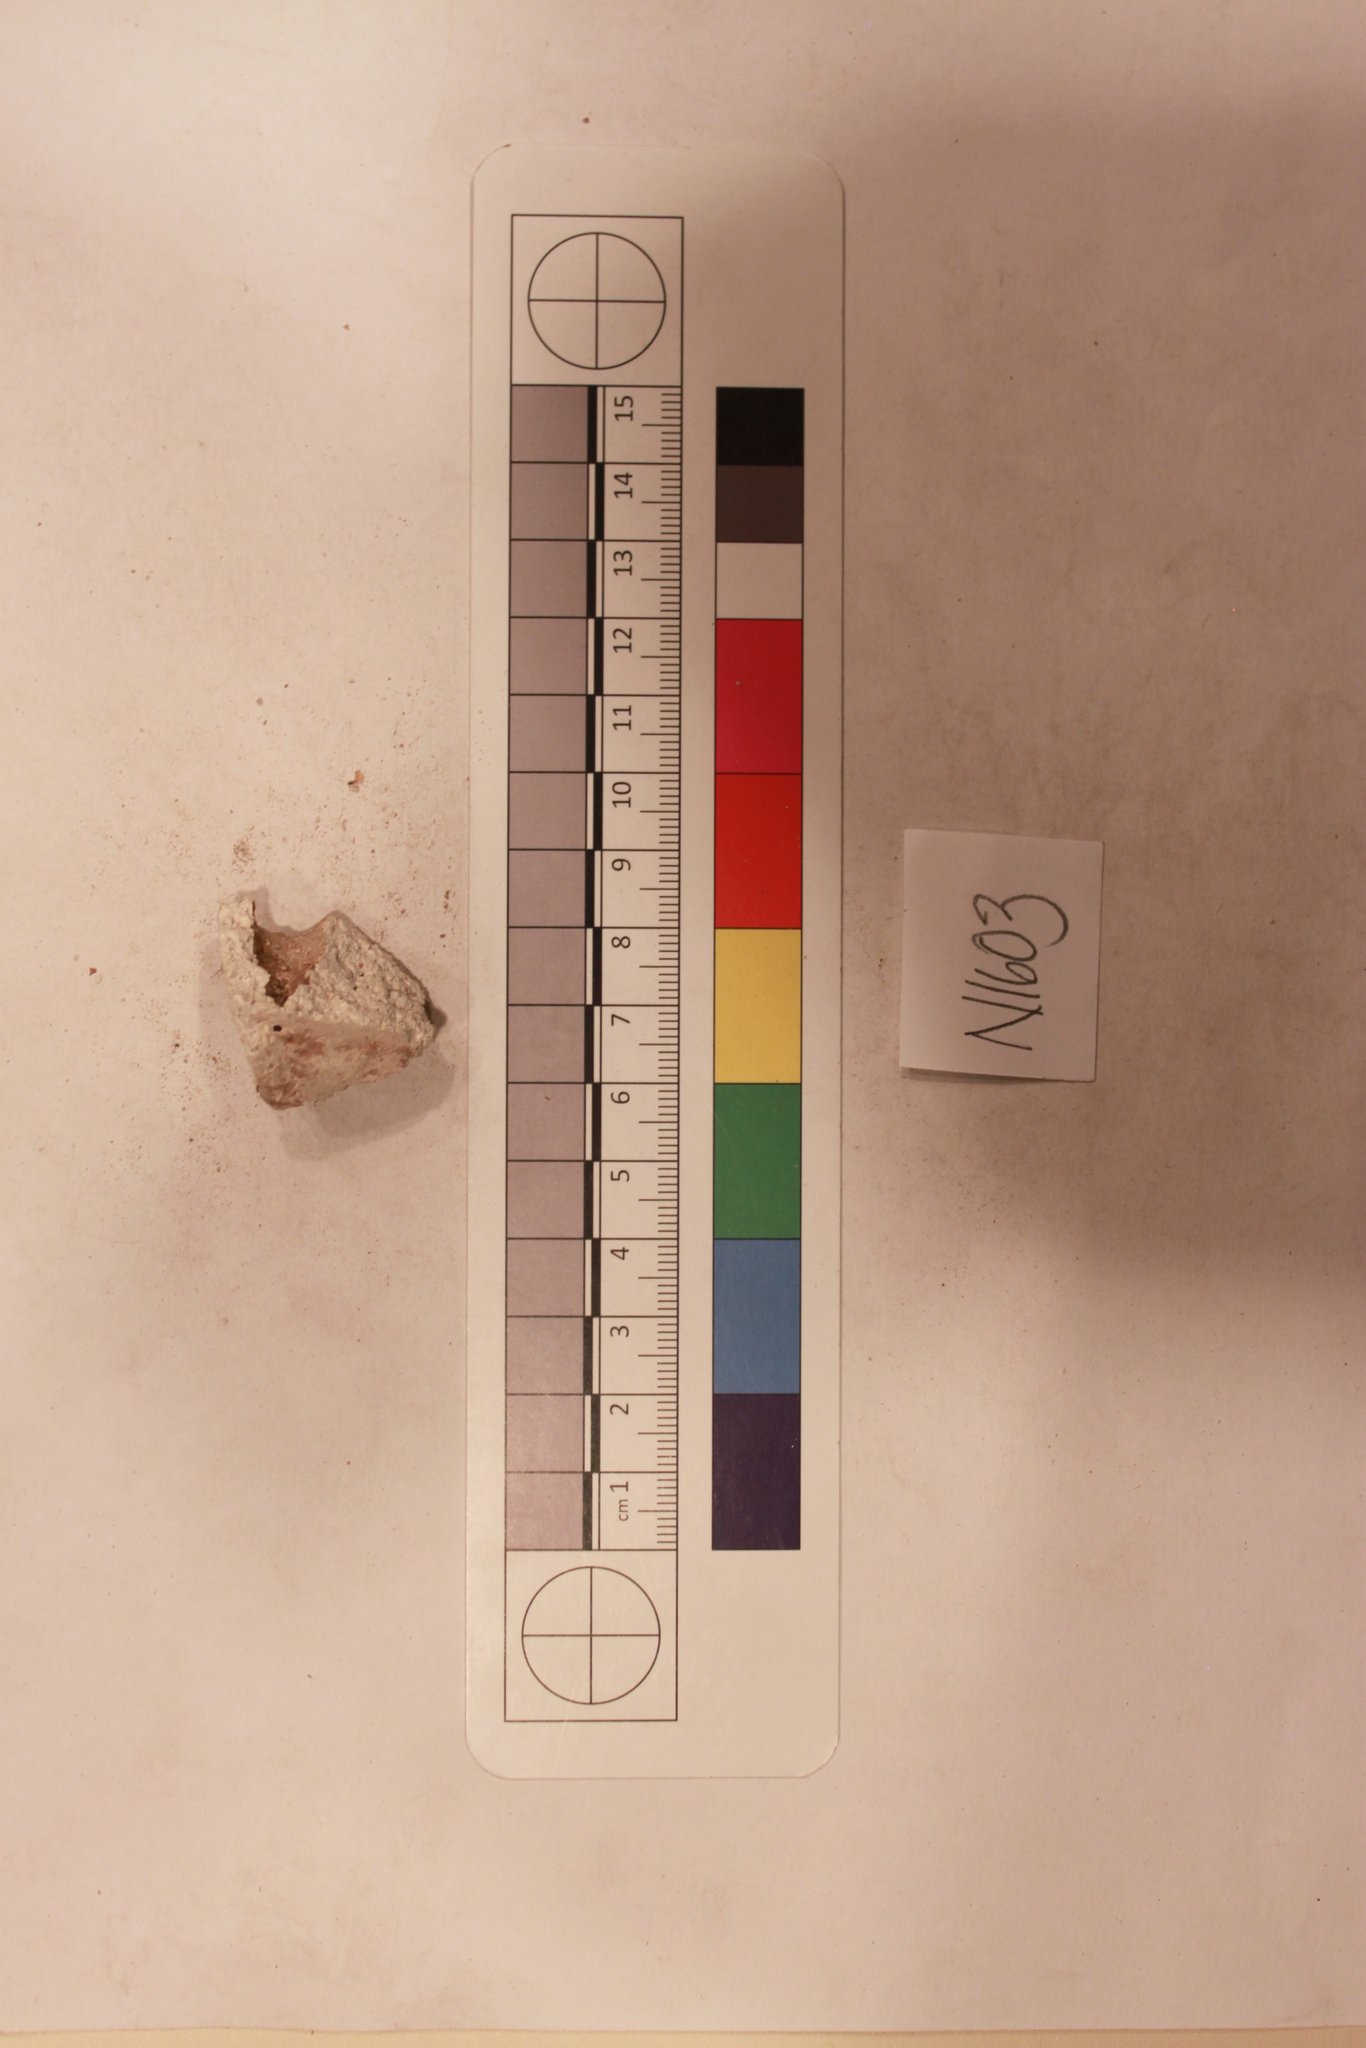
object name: fragment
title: Stucco Fragment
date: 701-1200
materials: plaster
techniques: carving, painting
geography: iran